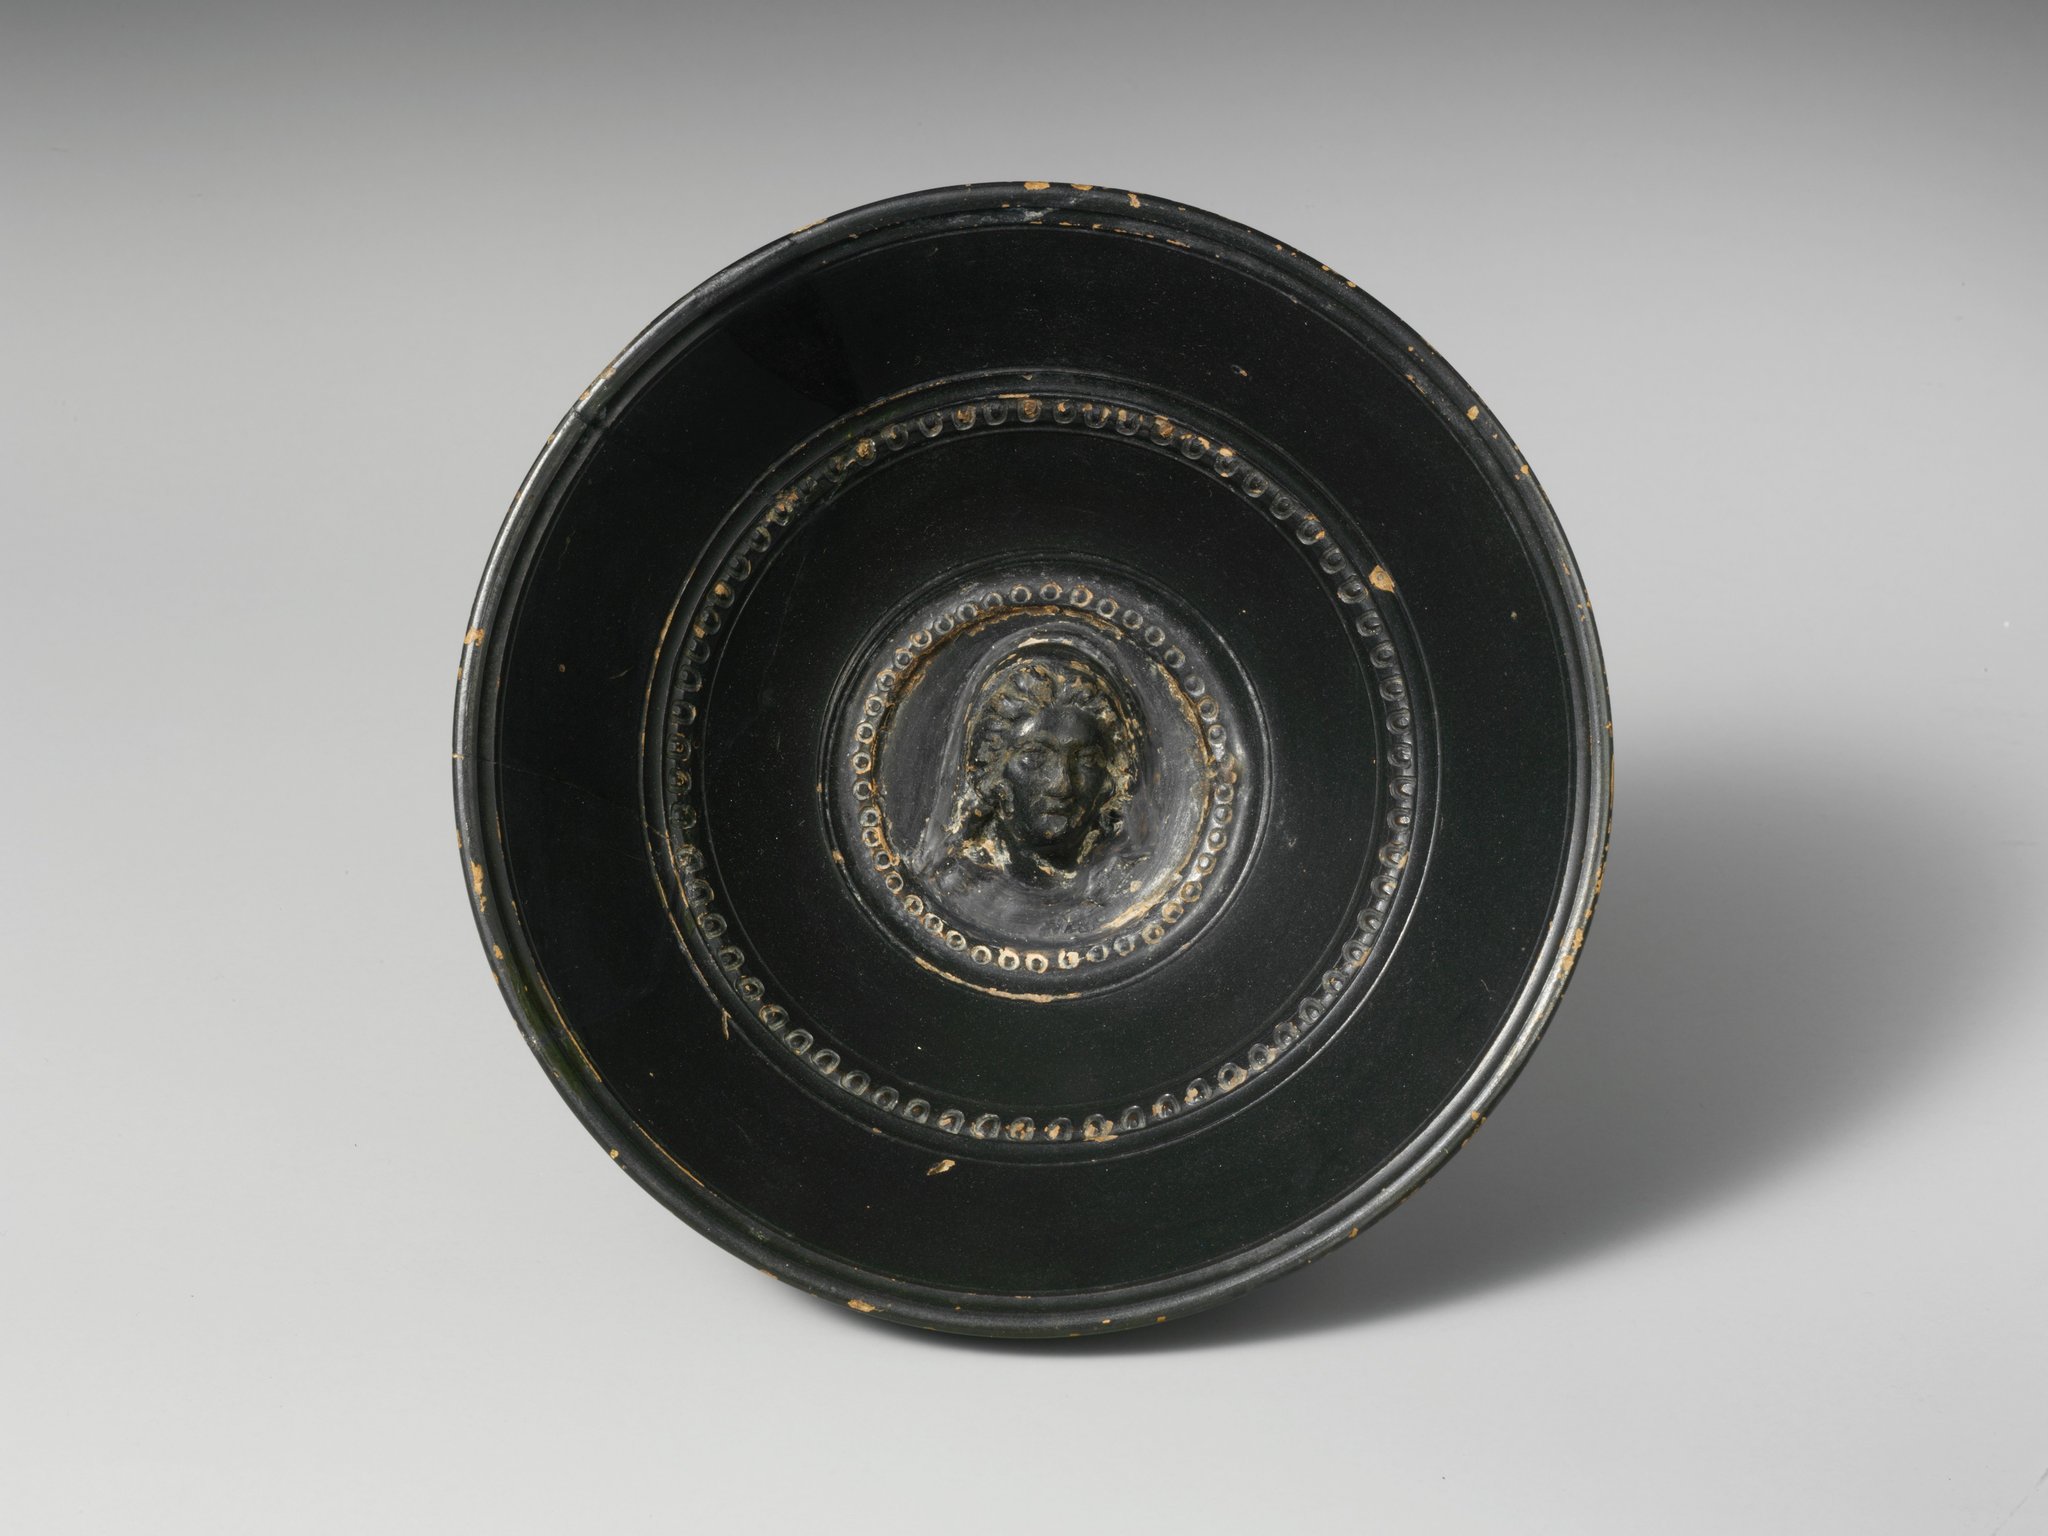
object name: bowl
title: Terracotta bowl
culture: etruscan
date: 400-201 BCE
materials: terracotta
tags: heads,women